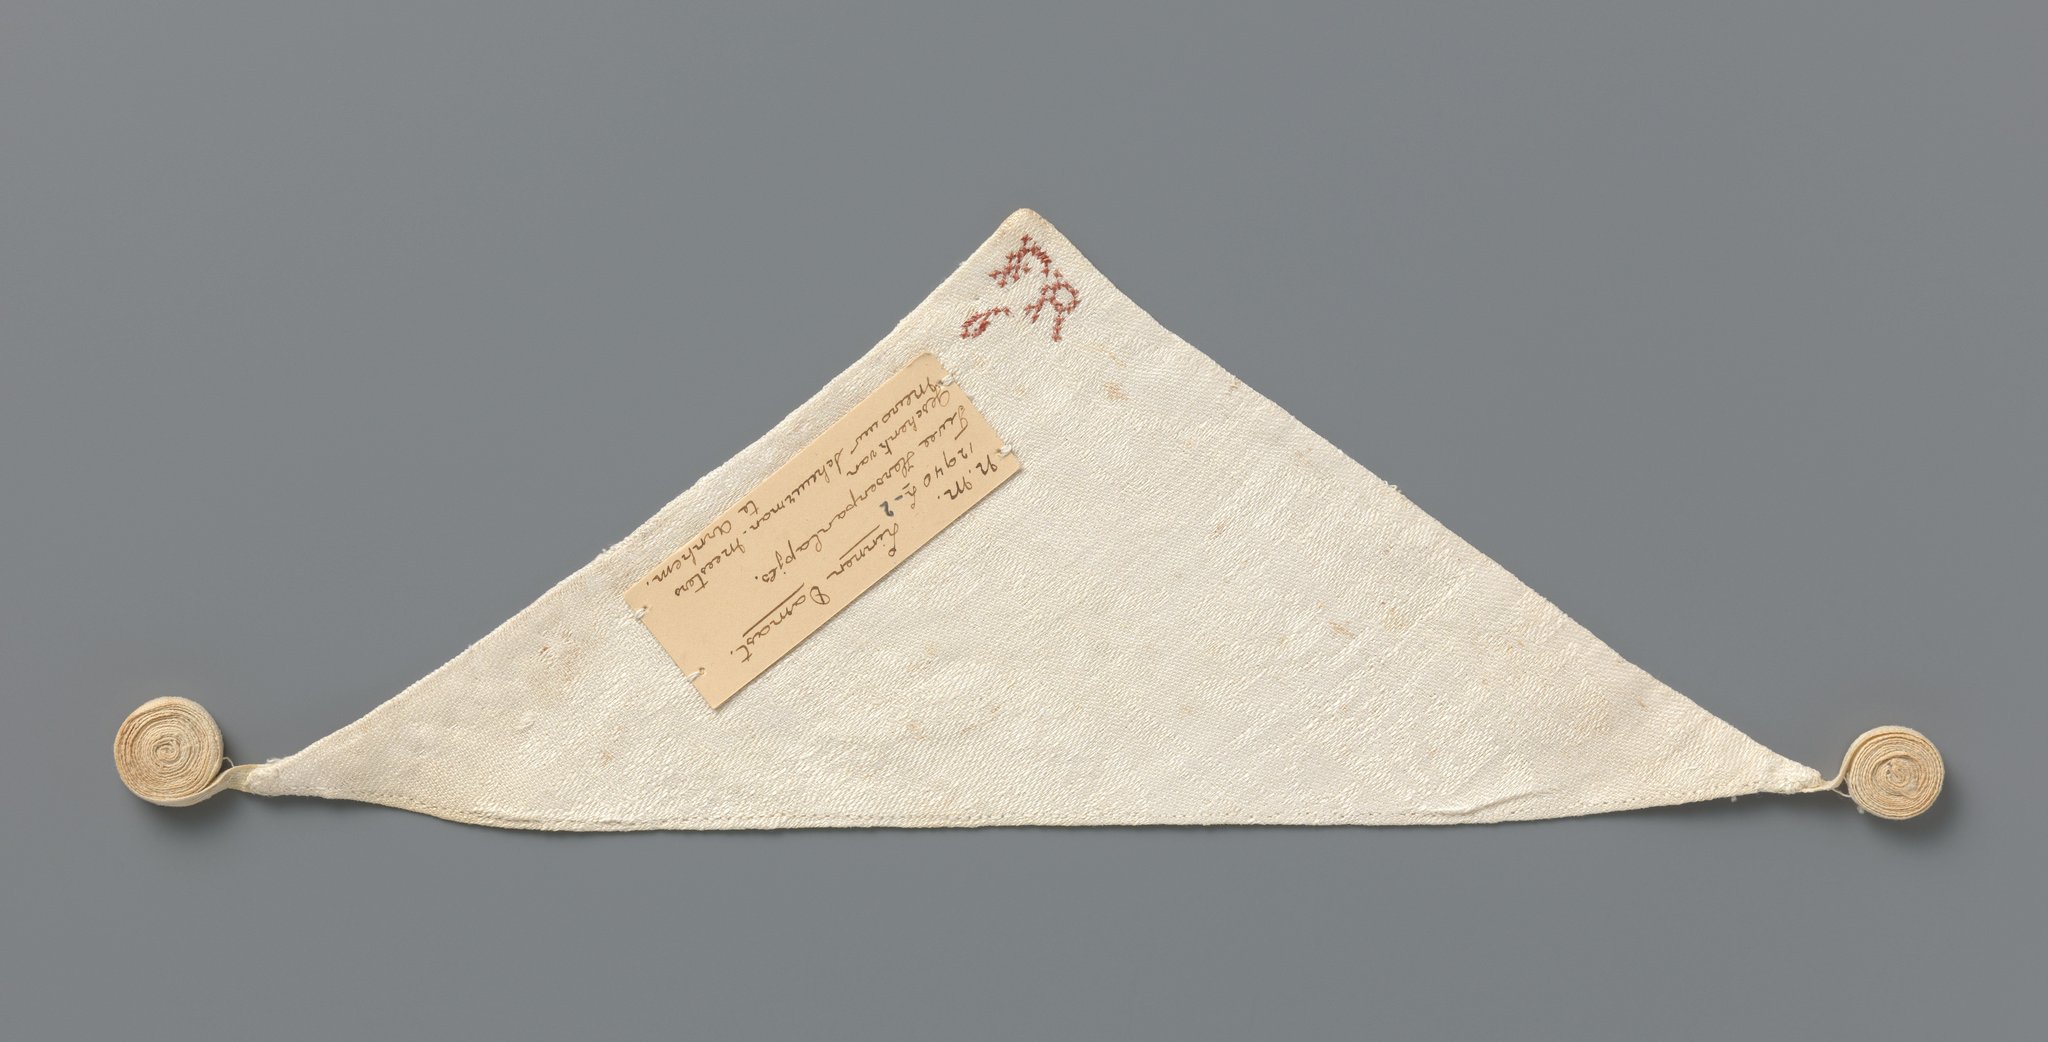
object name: childrenswear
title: Fontaneldoek van linnendamast, gemerkt met rode kruissteek: FR6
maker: Anonymous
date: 1750-1900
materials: linen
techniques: cross stitching, damask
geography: europe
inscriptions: inscription: ‘FR / 6’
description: Een hersenpanlapje - fontaneldoekje (?) - van linnendamast.